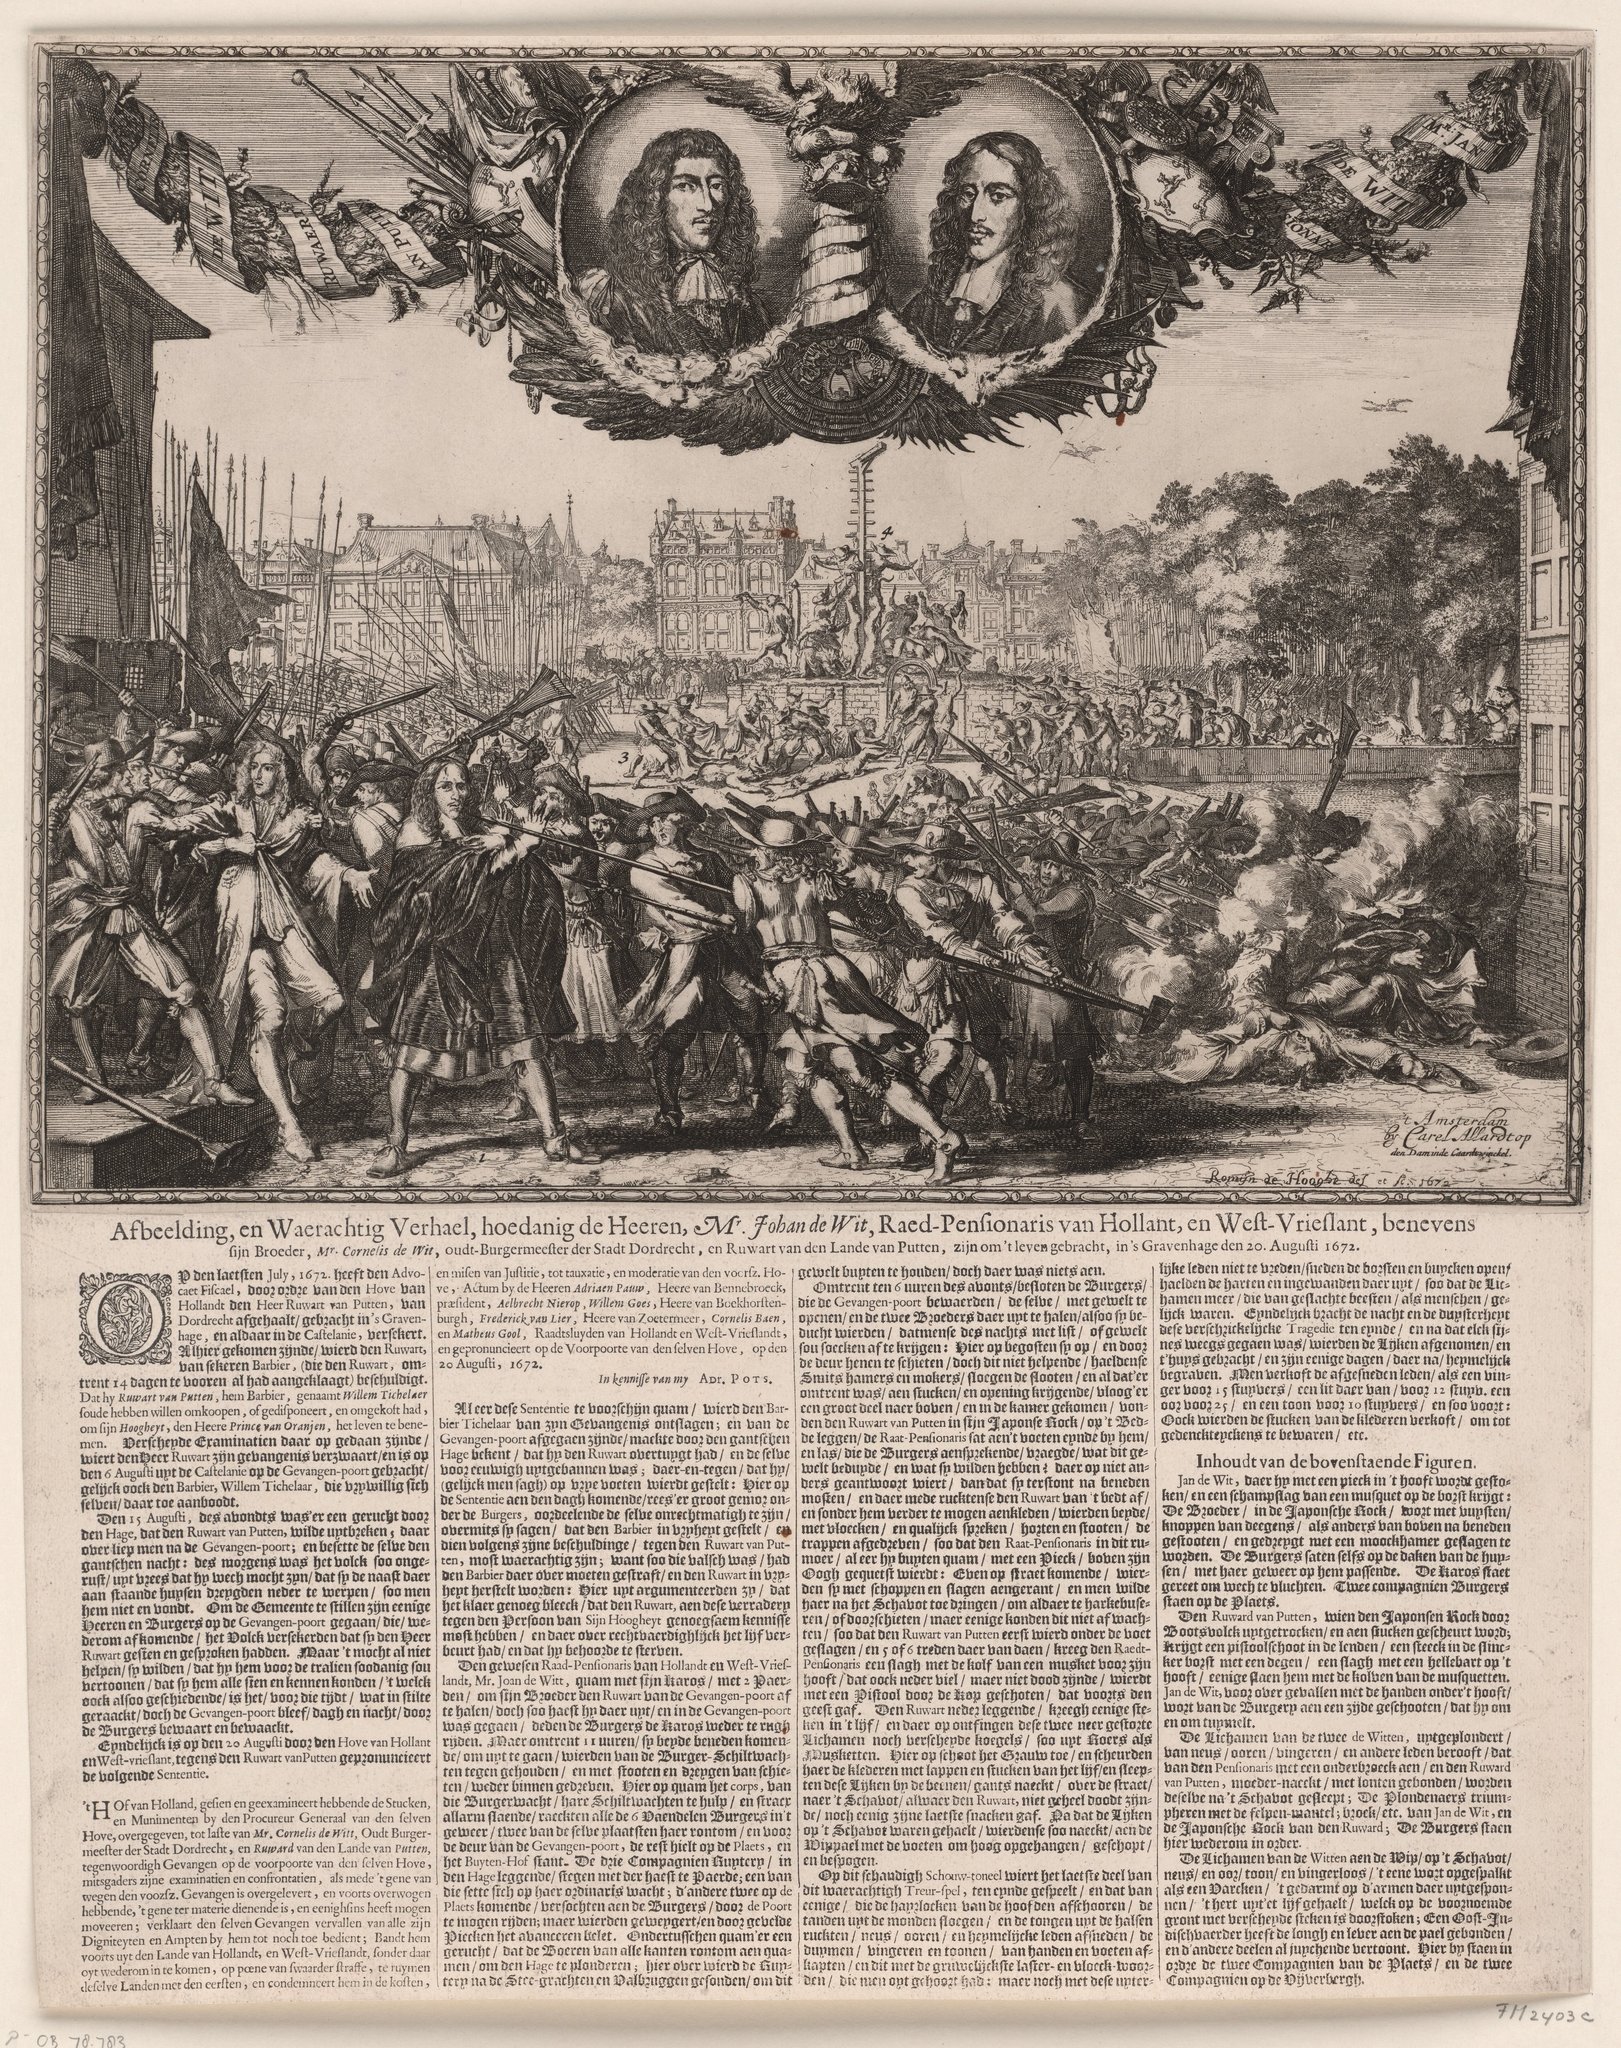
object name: print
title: Afbeelding, en Waerachtig Verhaal, hoedanig de Heeren, Mr. Johan de Wit, Raed-Pensionaris van Hollant, en West-Vrieslant, benevens zijn Broeder, Mr. Cornelis de Wit, oudt-Burgermeester der Stadt Dordrecht, en Ruwart van den Lande van Putten, zijn om't leven gebracht, in 's Gravenhage, den 20. Augusti 1672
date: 1672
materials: paper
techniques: engraving, etching, letterpress printing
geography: amsterdam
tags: dordrecht, cornelis de witt, johan de witt, lynching, attempt, political murder, violent death, being killed; being mishandled and maltreated; seeking death (+ death by lynching), the hague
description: Prent waarin de verschillende episodes van de moord op de gebroeders De Witt tot één grote voorstelling zijn verwerkt. Bovenin de voorstelling zijn portretten van Johan en Cornelis de Witt aangebracht. Onderaan staan dezelfde beschrijvingen van de gebeurtenissen in 4 kolommen in het Nederlands, en een uitleg van de afbeelding, als in FMH 2401a.